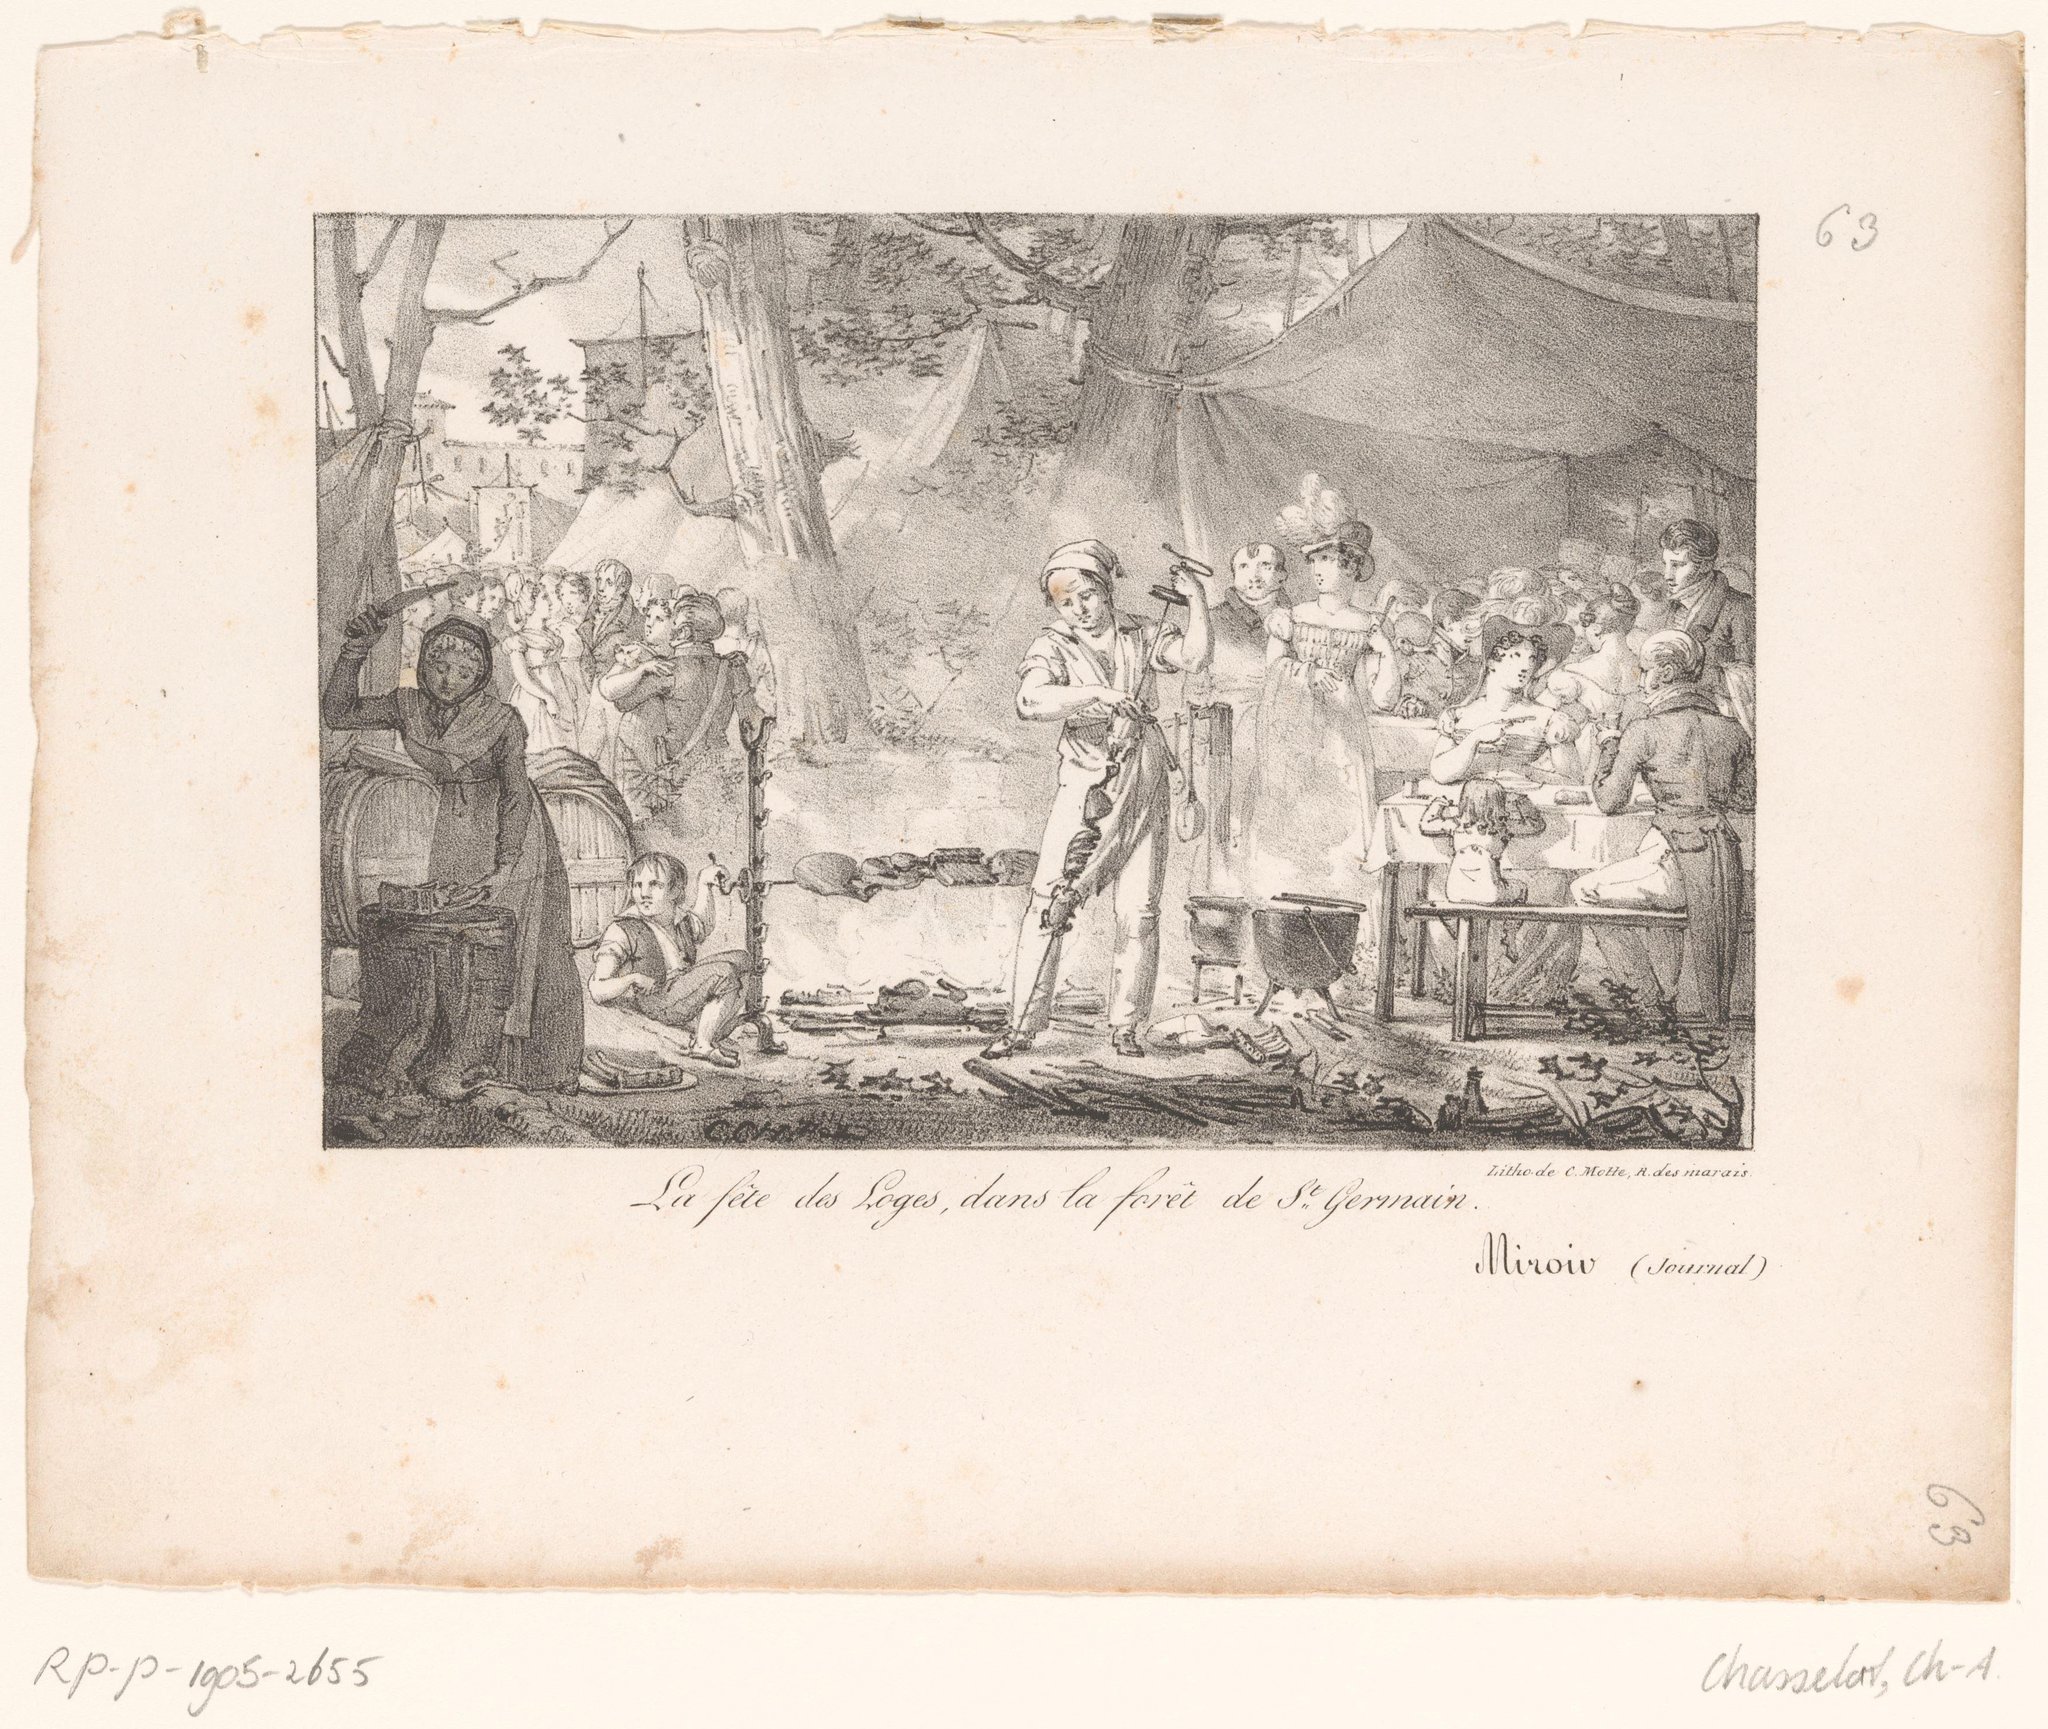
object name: print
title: La fête des Loges, dans la forêt de St. Germain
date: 1820-1833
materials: paper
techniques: lithograph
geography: paris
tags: public festivities (+ eating and drinking ~ festive activities), spit ~ cooking - cc - in the open air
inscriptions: collector's mark: Lugt 2228a, number: ‘63’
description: Het 'Fête des Loges' is een feest dat sinds 1652 elk jaar in de zomer plaatsvindt in het bos van Saint-Germain-en-Laye.